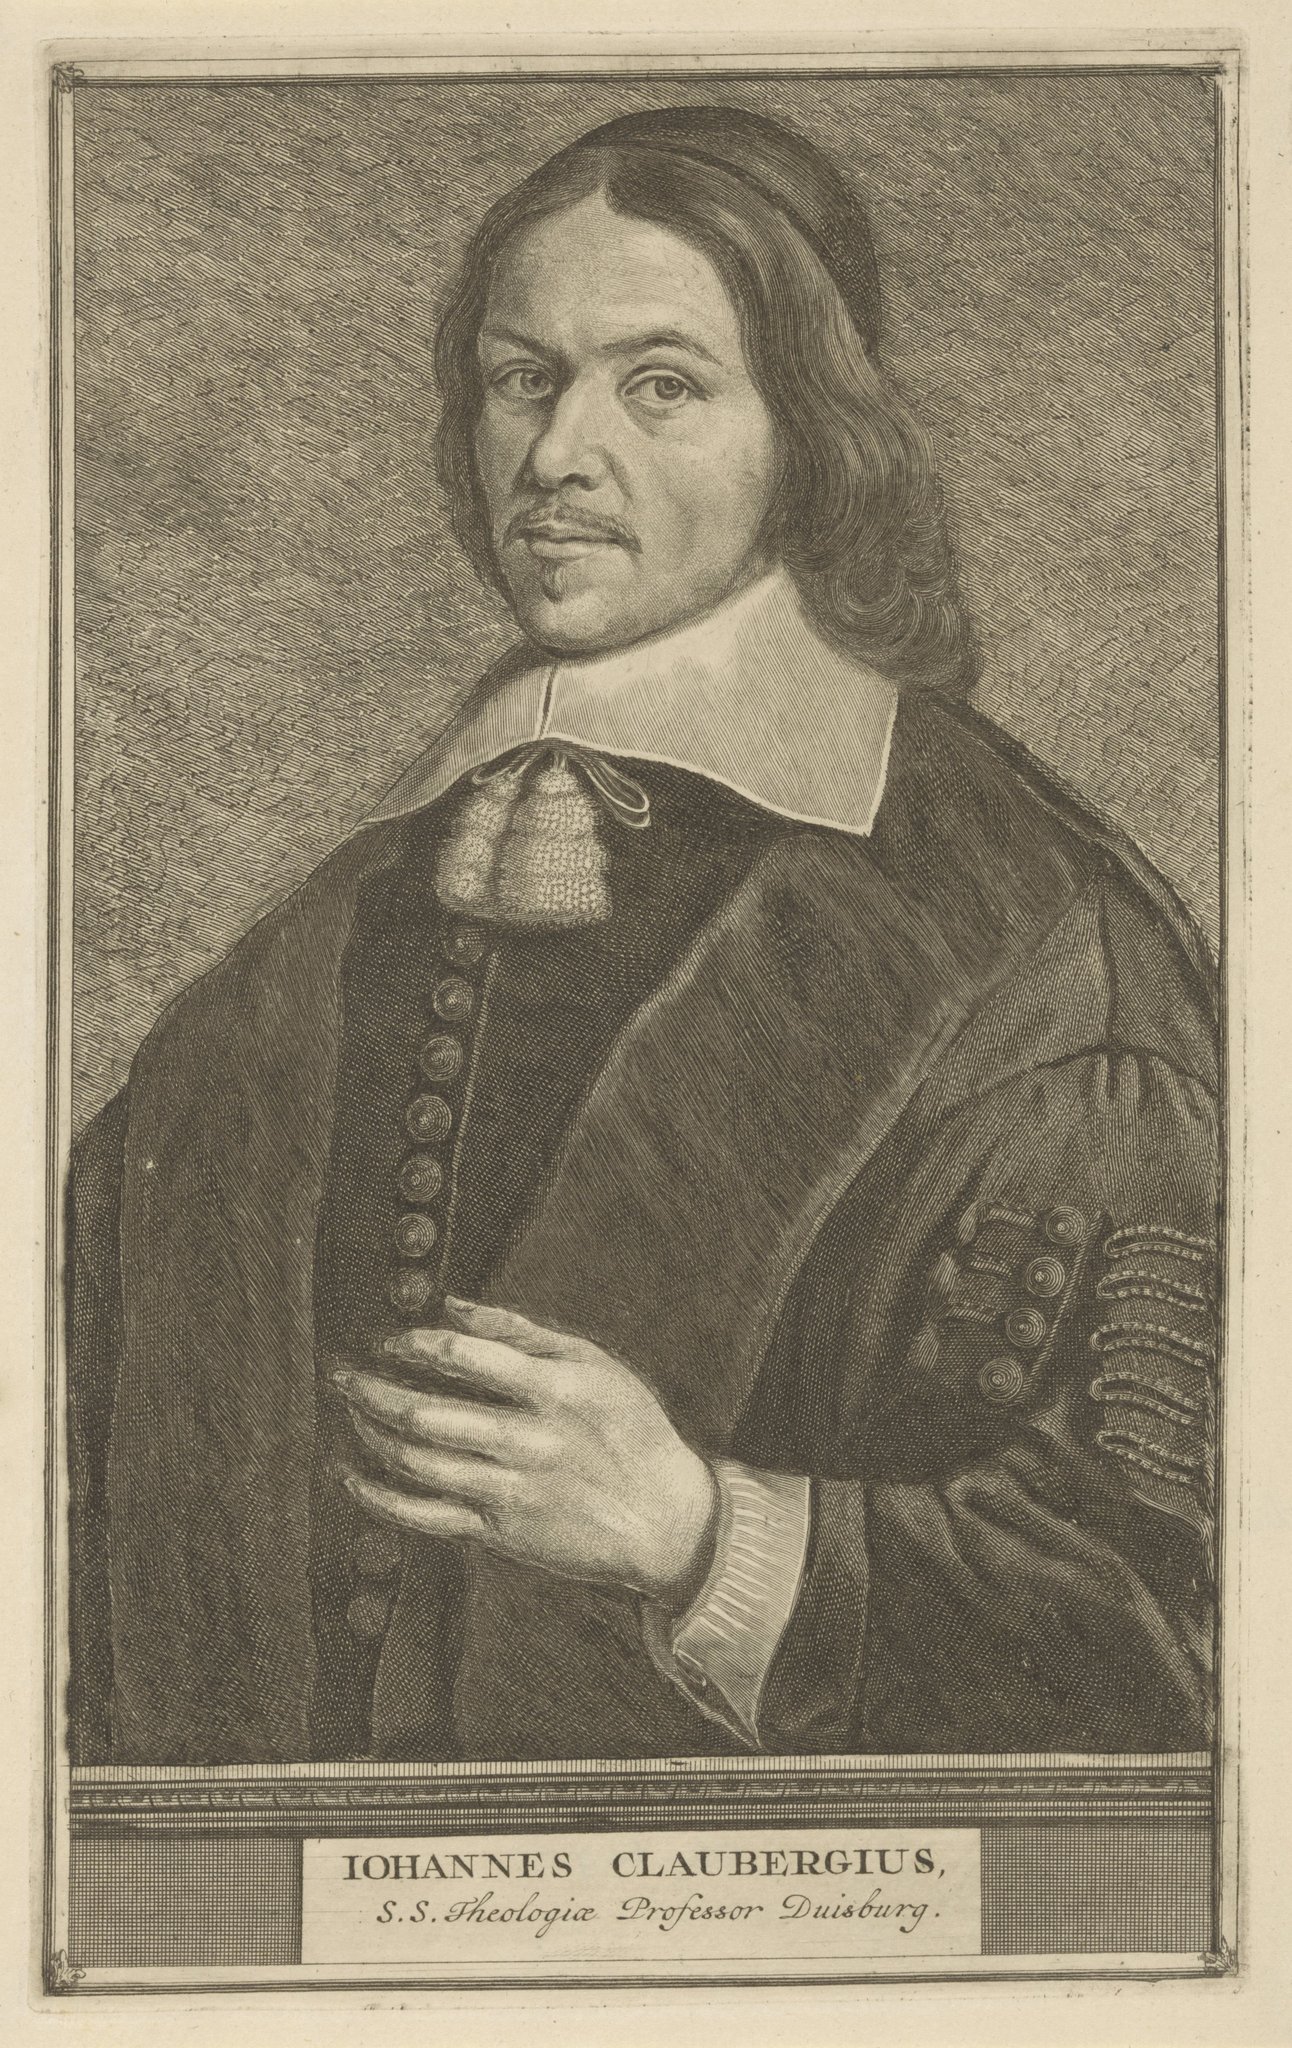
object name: print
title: Portret van Johannes Clauberg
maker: jonas suyderhoef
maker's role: draughtsman, print maker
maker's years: 1613-1686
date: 1655-1665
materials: paper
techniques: engraving, etching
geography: haarlem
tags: scholar, philosopher, professor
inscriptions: collector's mark: Lugt 2228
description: Portret van Johannes Clauberg, hoogleraar theologie en filosofie aan de door hem gestichtte eerste universiteit van Duisburg. Onderaan op een randlijst zijn naam en functie in het Latijn.